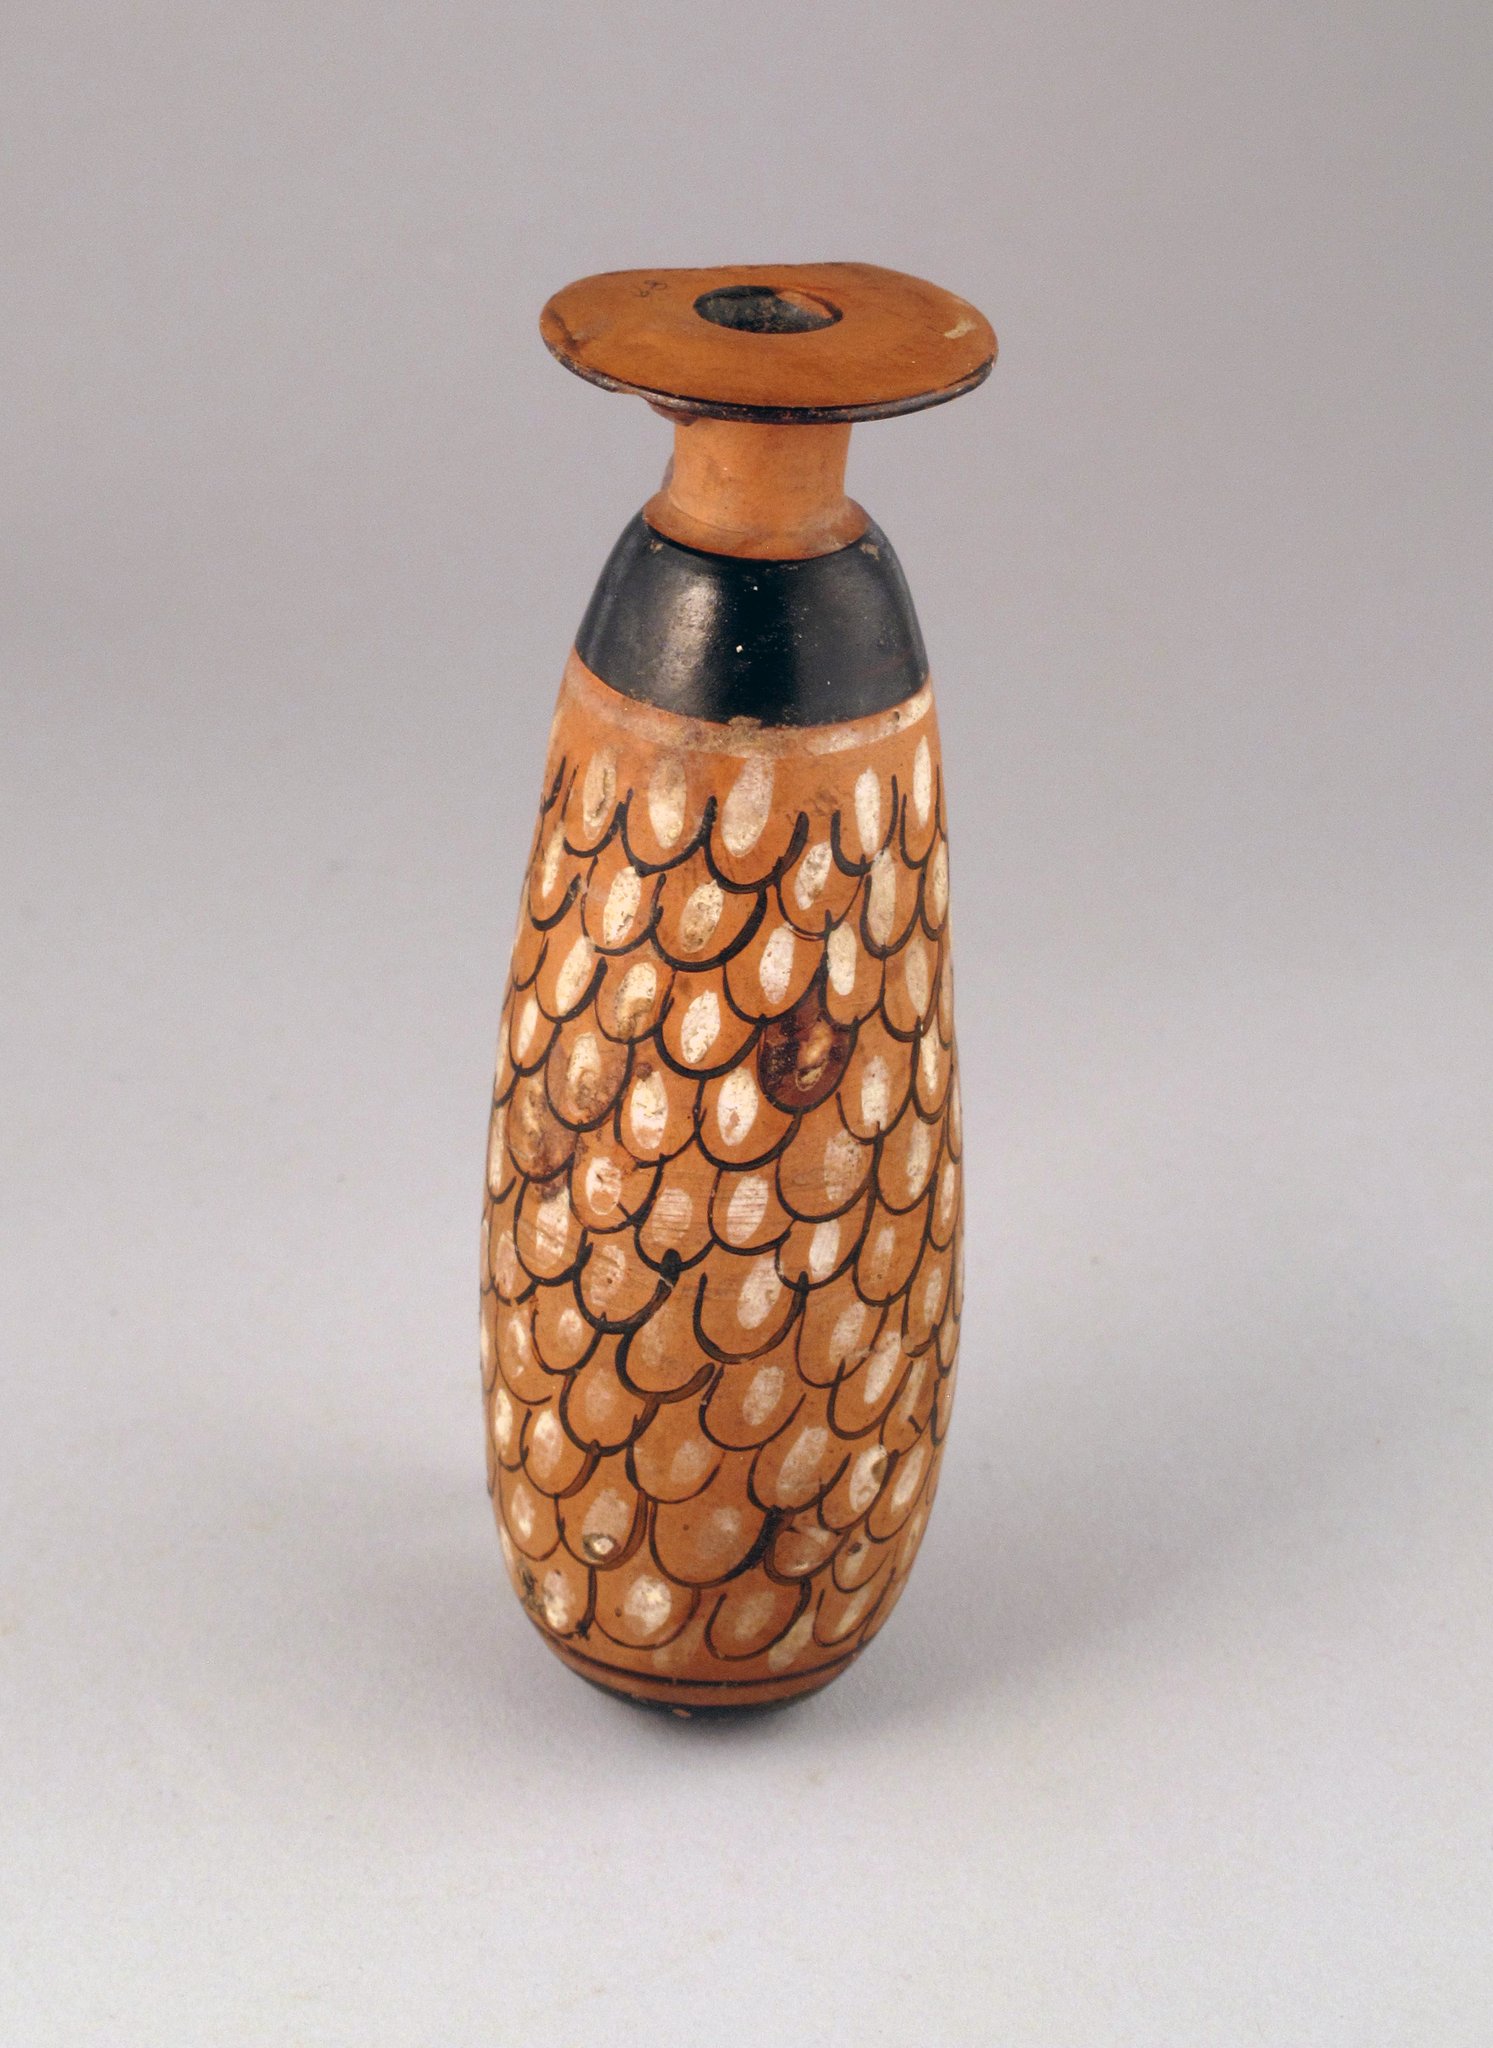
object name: alabastron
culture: greek, attic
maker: bulas group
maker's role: artist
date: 400-368 BCE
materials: terracotta